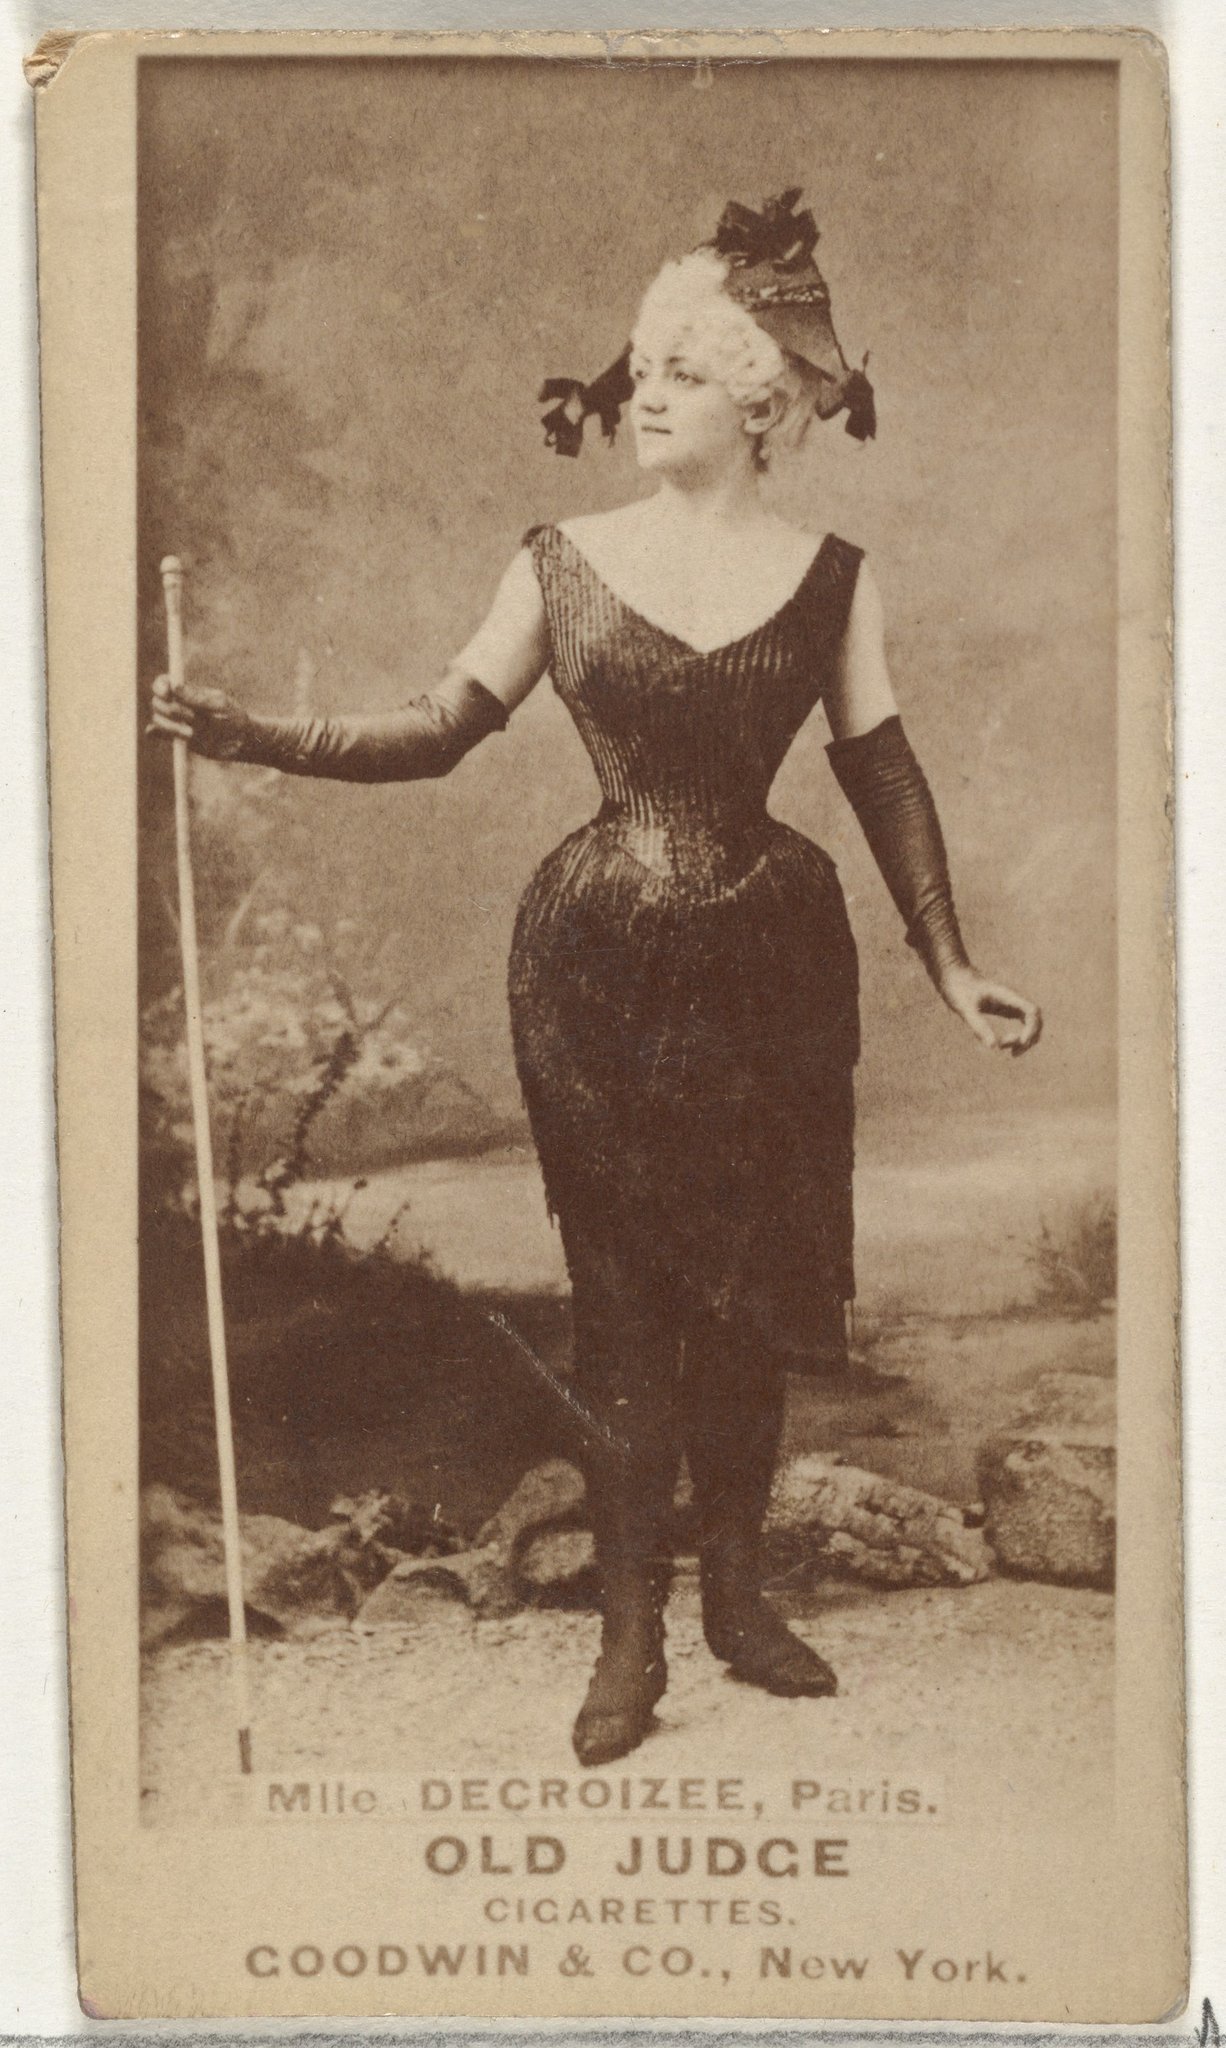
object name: photograph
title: Mlle. Decroizee, Paris, from the Actors and Actresses series (N171) for Old Judge Cigarettes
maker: goodwin & company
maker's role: publisher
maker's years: 1850-1950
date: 1886-1890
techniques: albumen silver print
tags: portraits,women,actresses